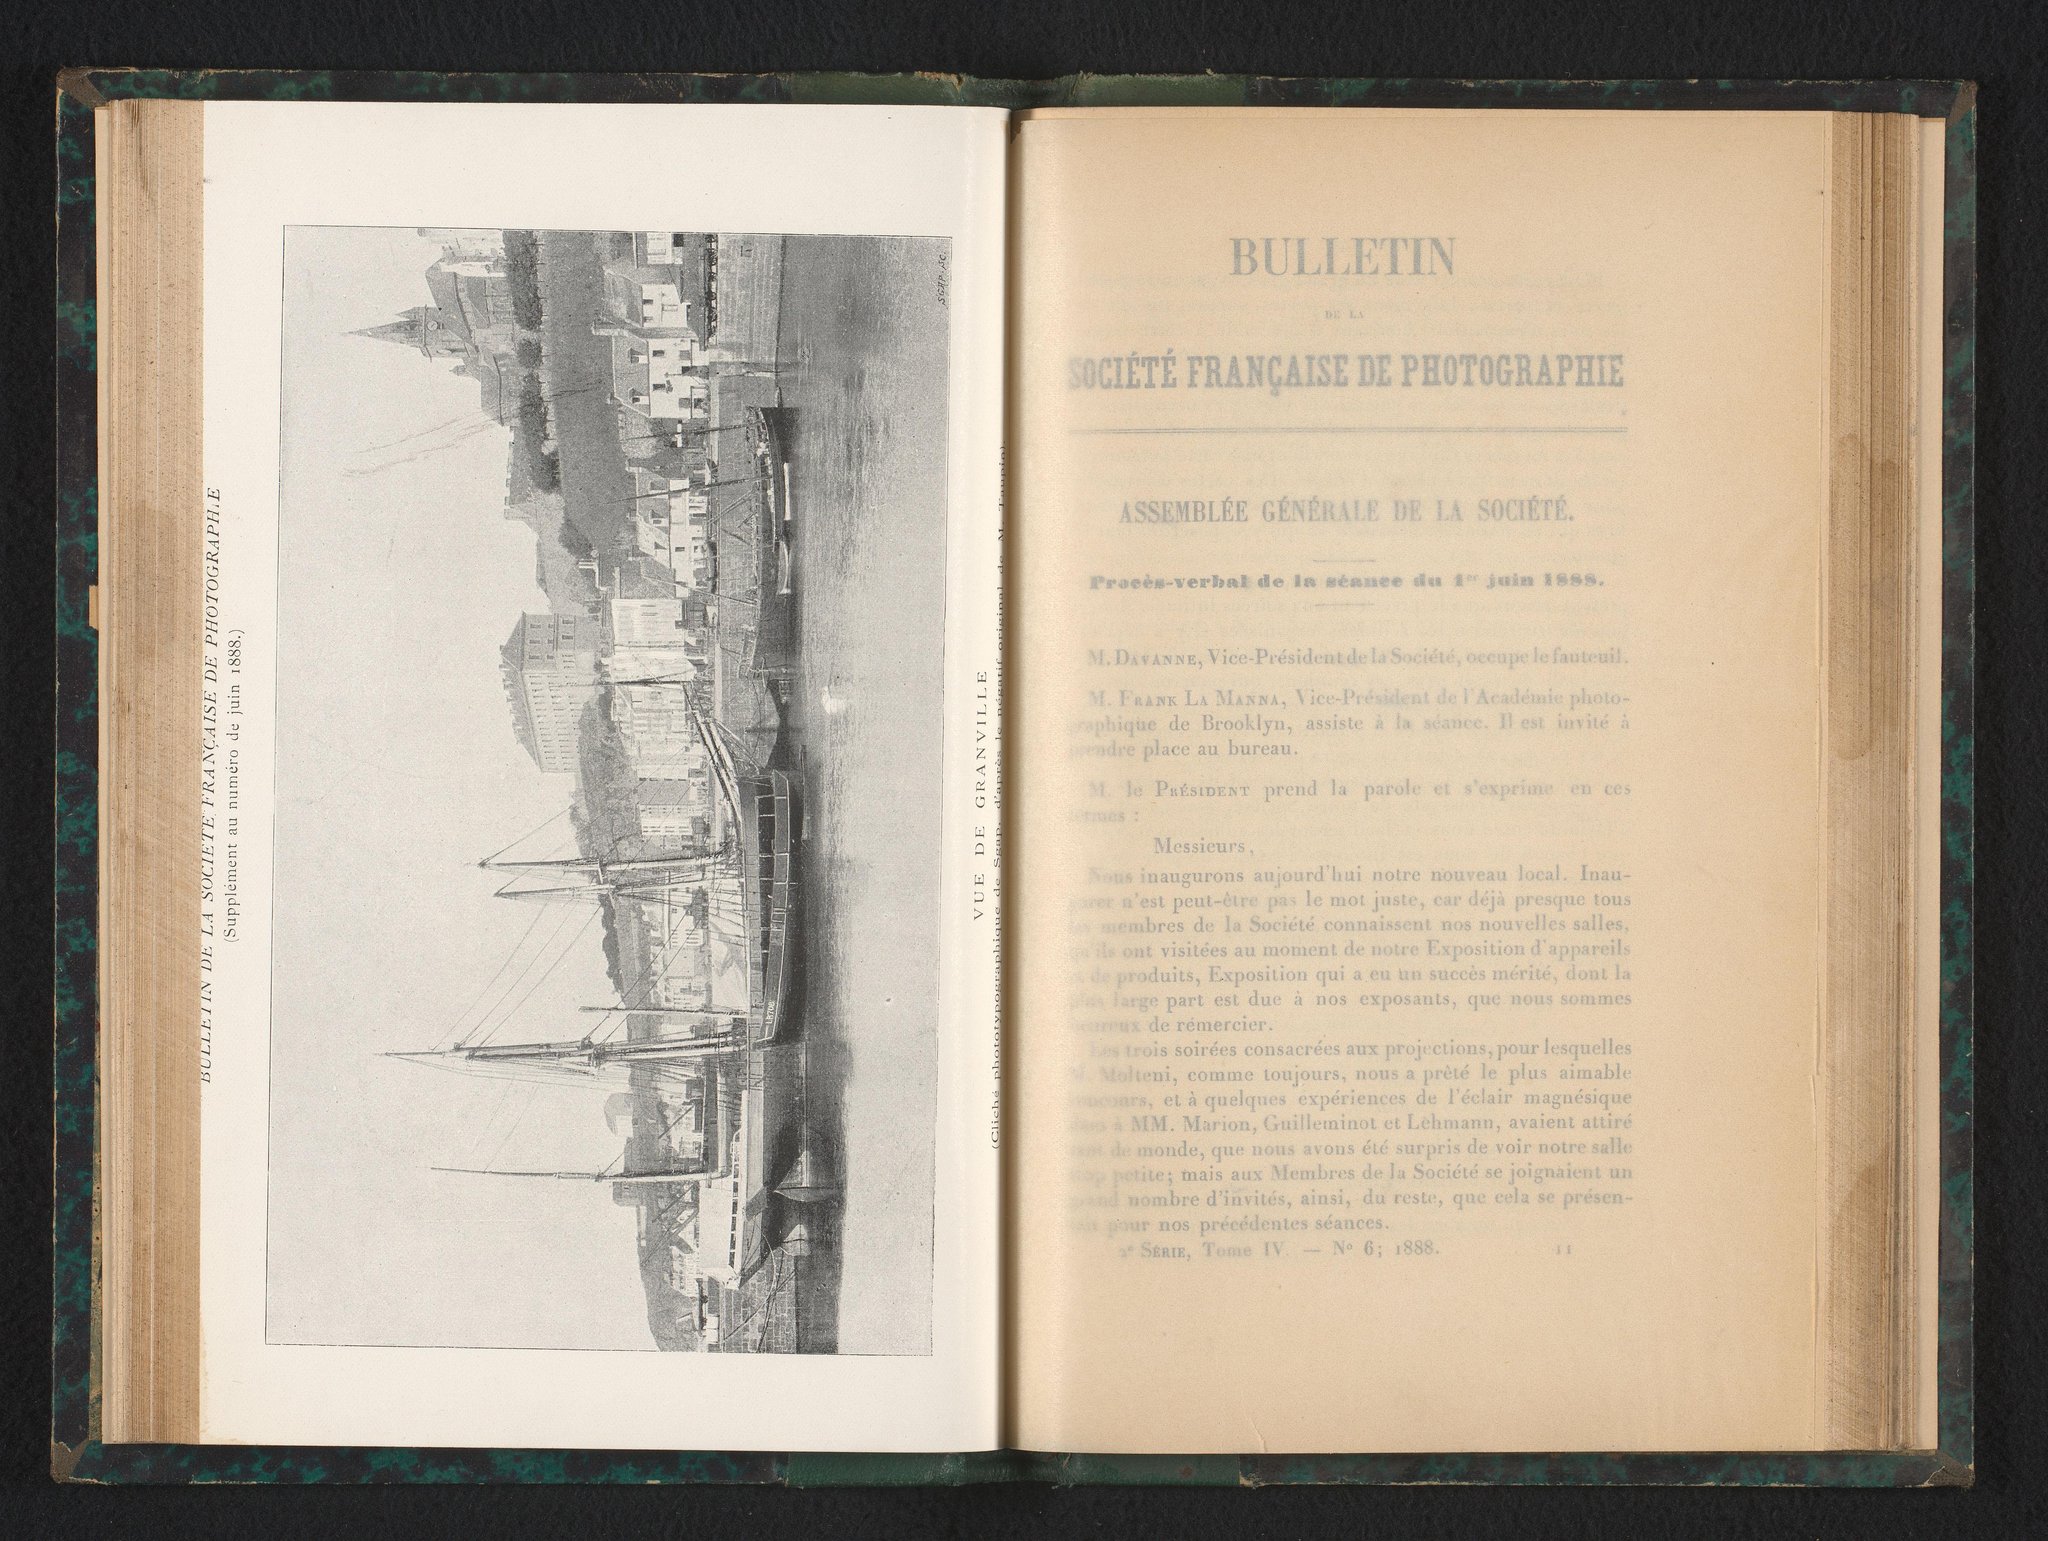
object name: photomechanical print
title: Vue de Granville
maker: a. taupin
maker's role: fotograaf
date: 1883-1888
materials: paper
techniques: autotype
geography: paris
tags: harbour, city-view in general; 'veduta'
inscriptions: inscription: ‘(Supplément au numéro de juin 1888.)’, signature: ‘SGAP SC’